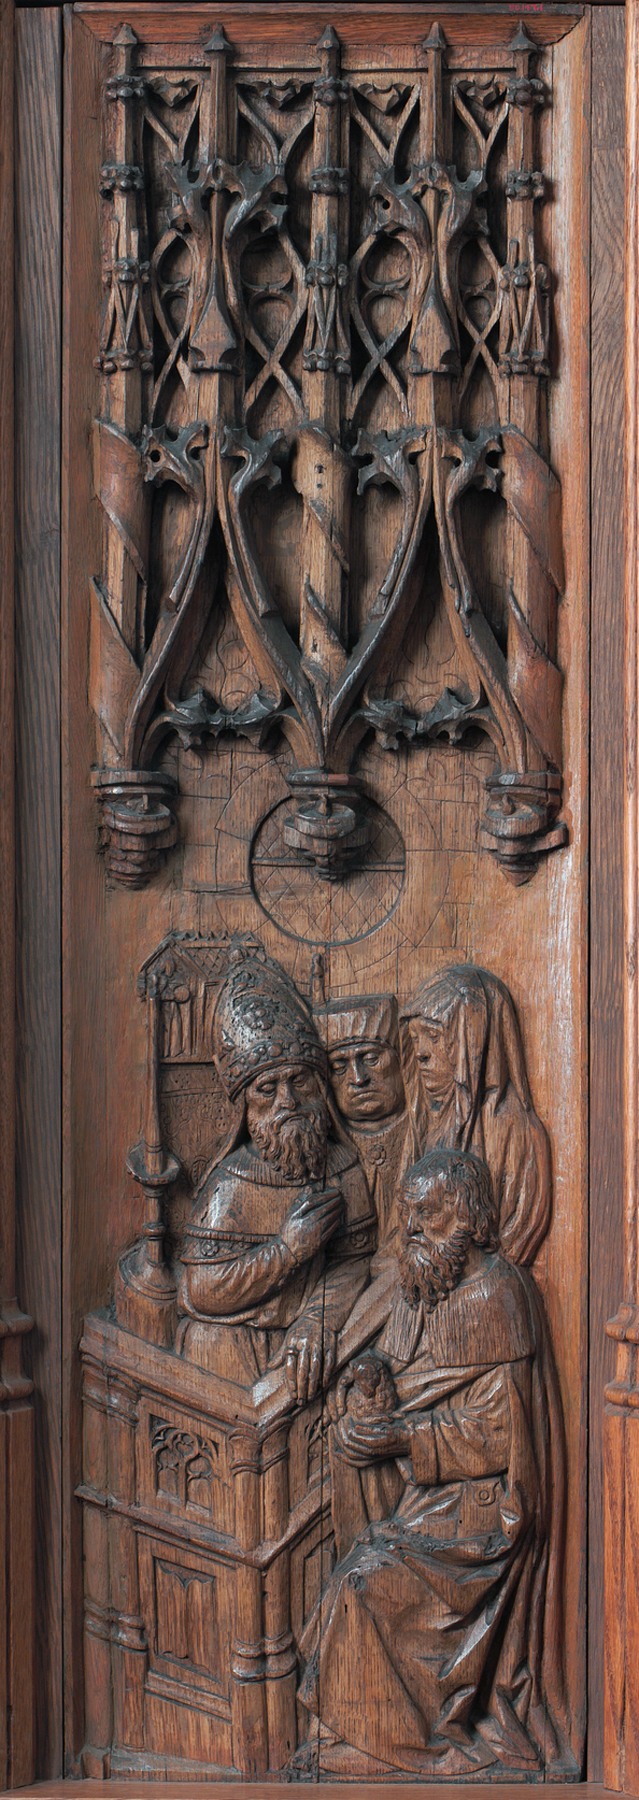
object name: panel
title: Panel with Joachim's Offering Rejected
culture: french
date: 1501-1533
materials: wood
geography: france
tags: christ,virgin mary